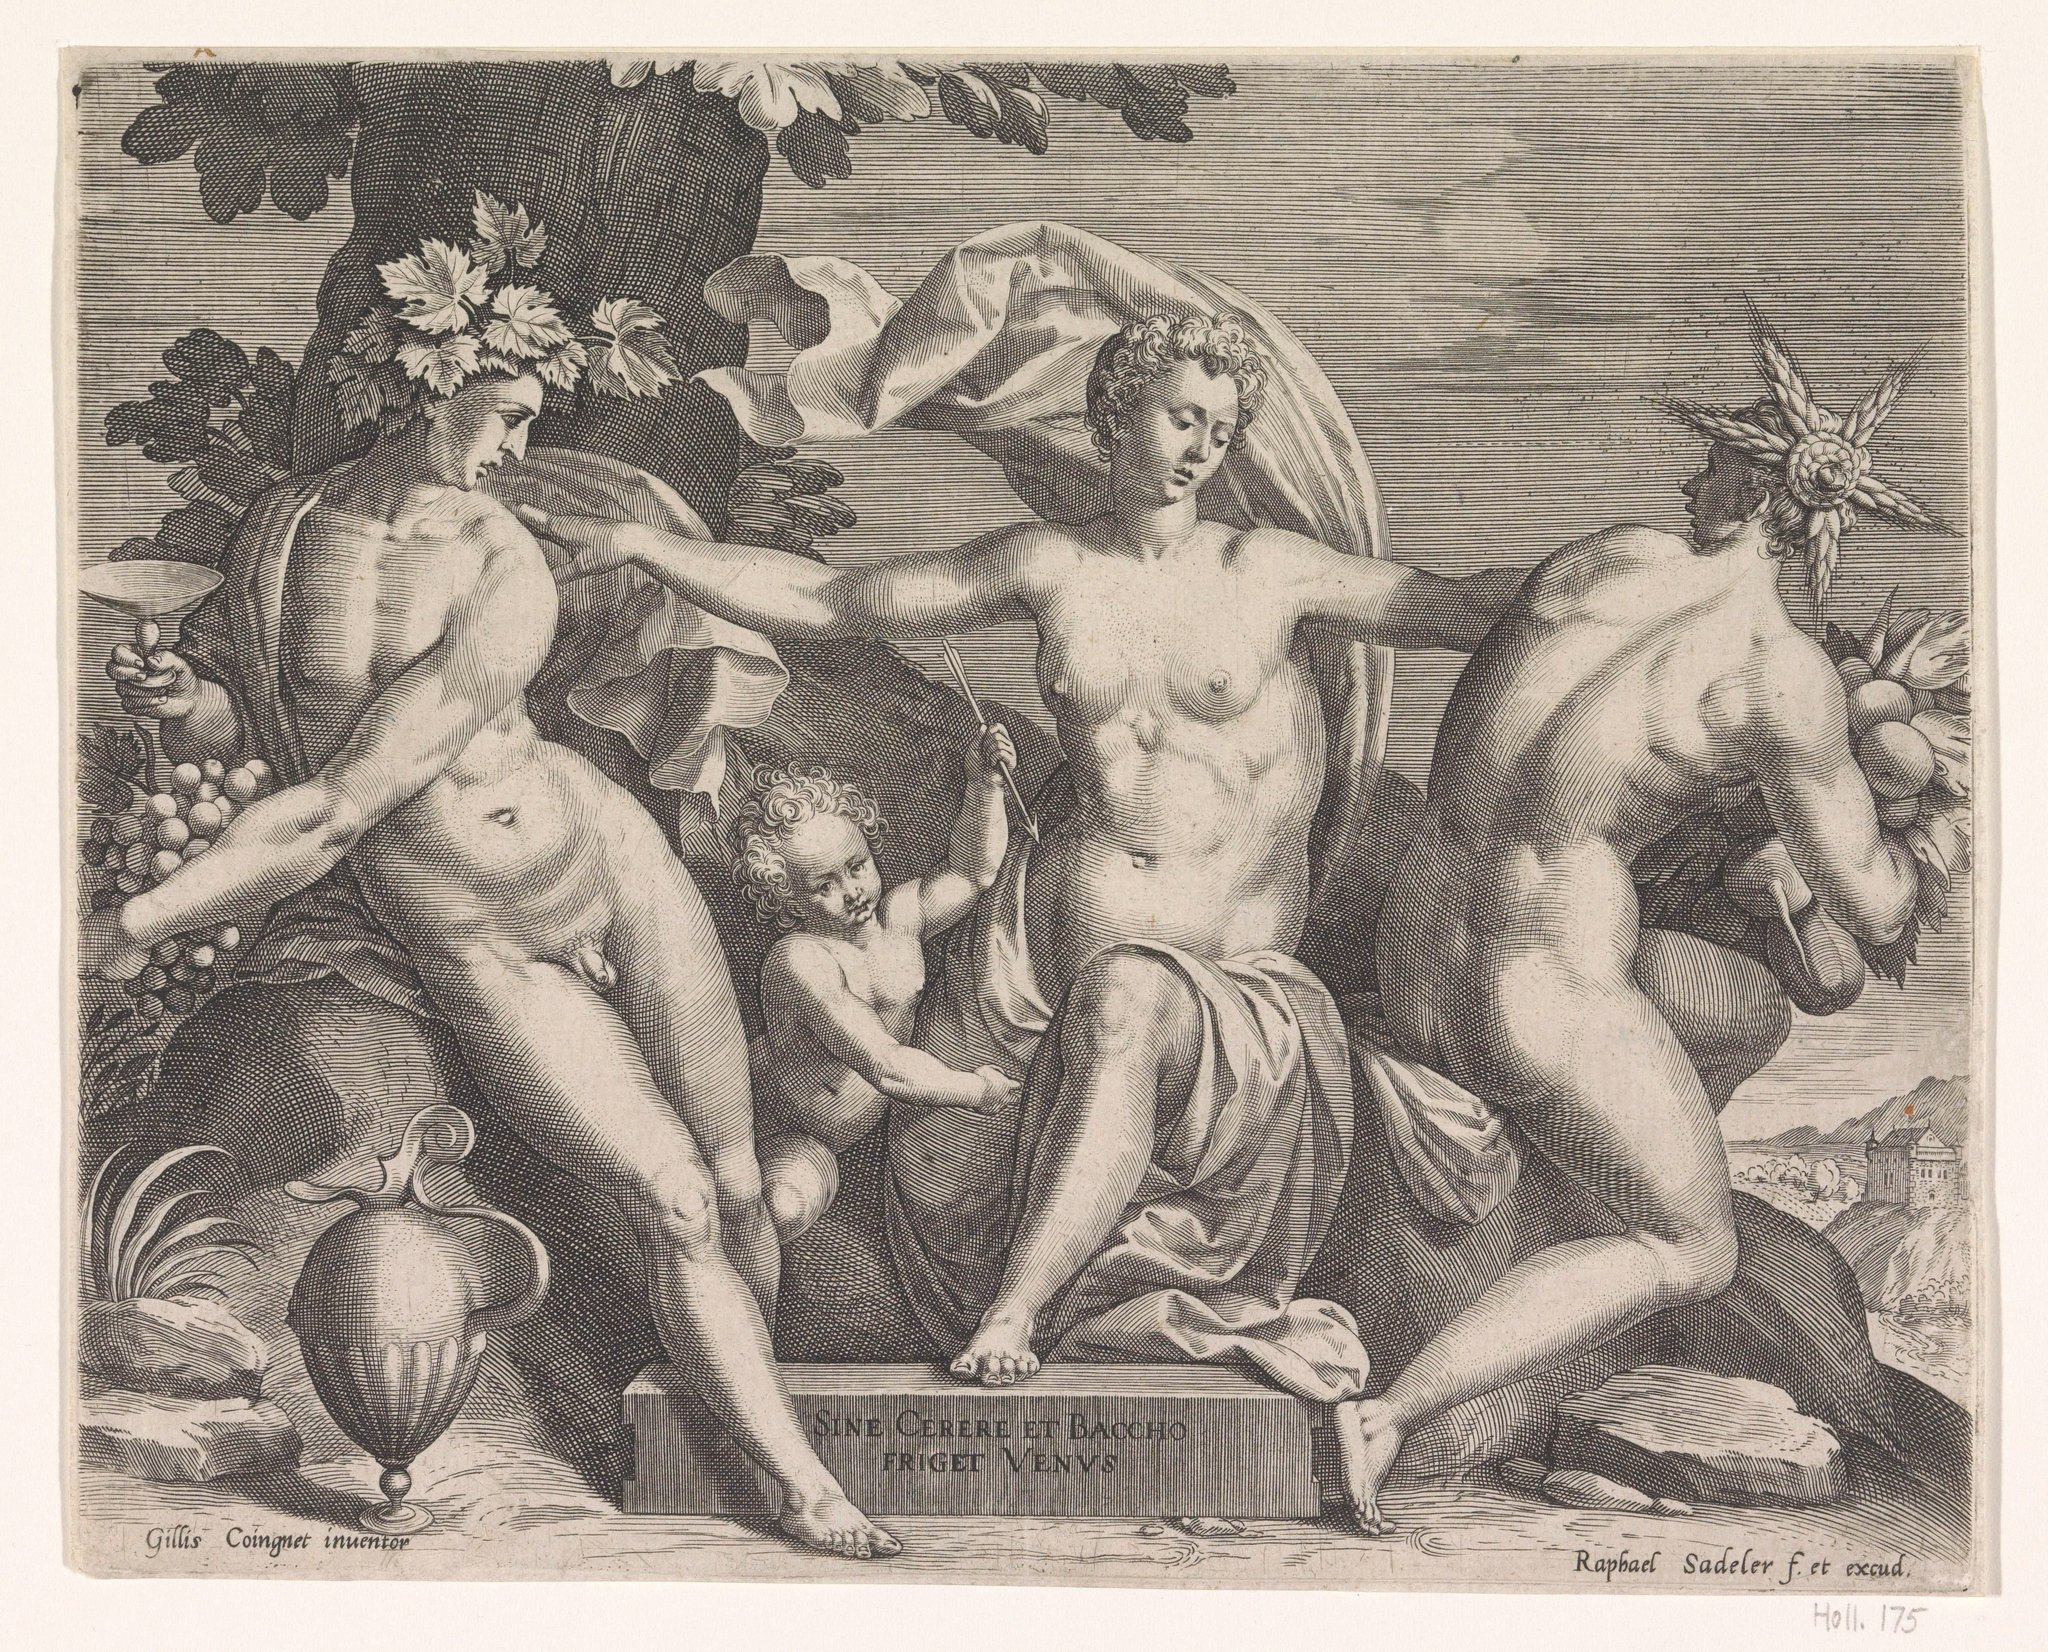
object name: print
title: Venus, Bacchus en Ceres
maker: raphaël sadeler (i)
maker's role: print maker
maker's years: 1560-1628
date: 1570-1632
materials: paper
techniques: engraving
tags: (story of) ceres (demeter), (story of) bacchus (dionysus), liber, (story of) venus (aphrodite)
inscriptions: inscription: ‘P.M. 1674’, collector's mark: Lugt 2228, collector's mark: Lugt 2760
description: De godin Venus en Amor tussen Bacchus (links) en Ceres (rechts).